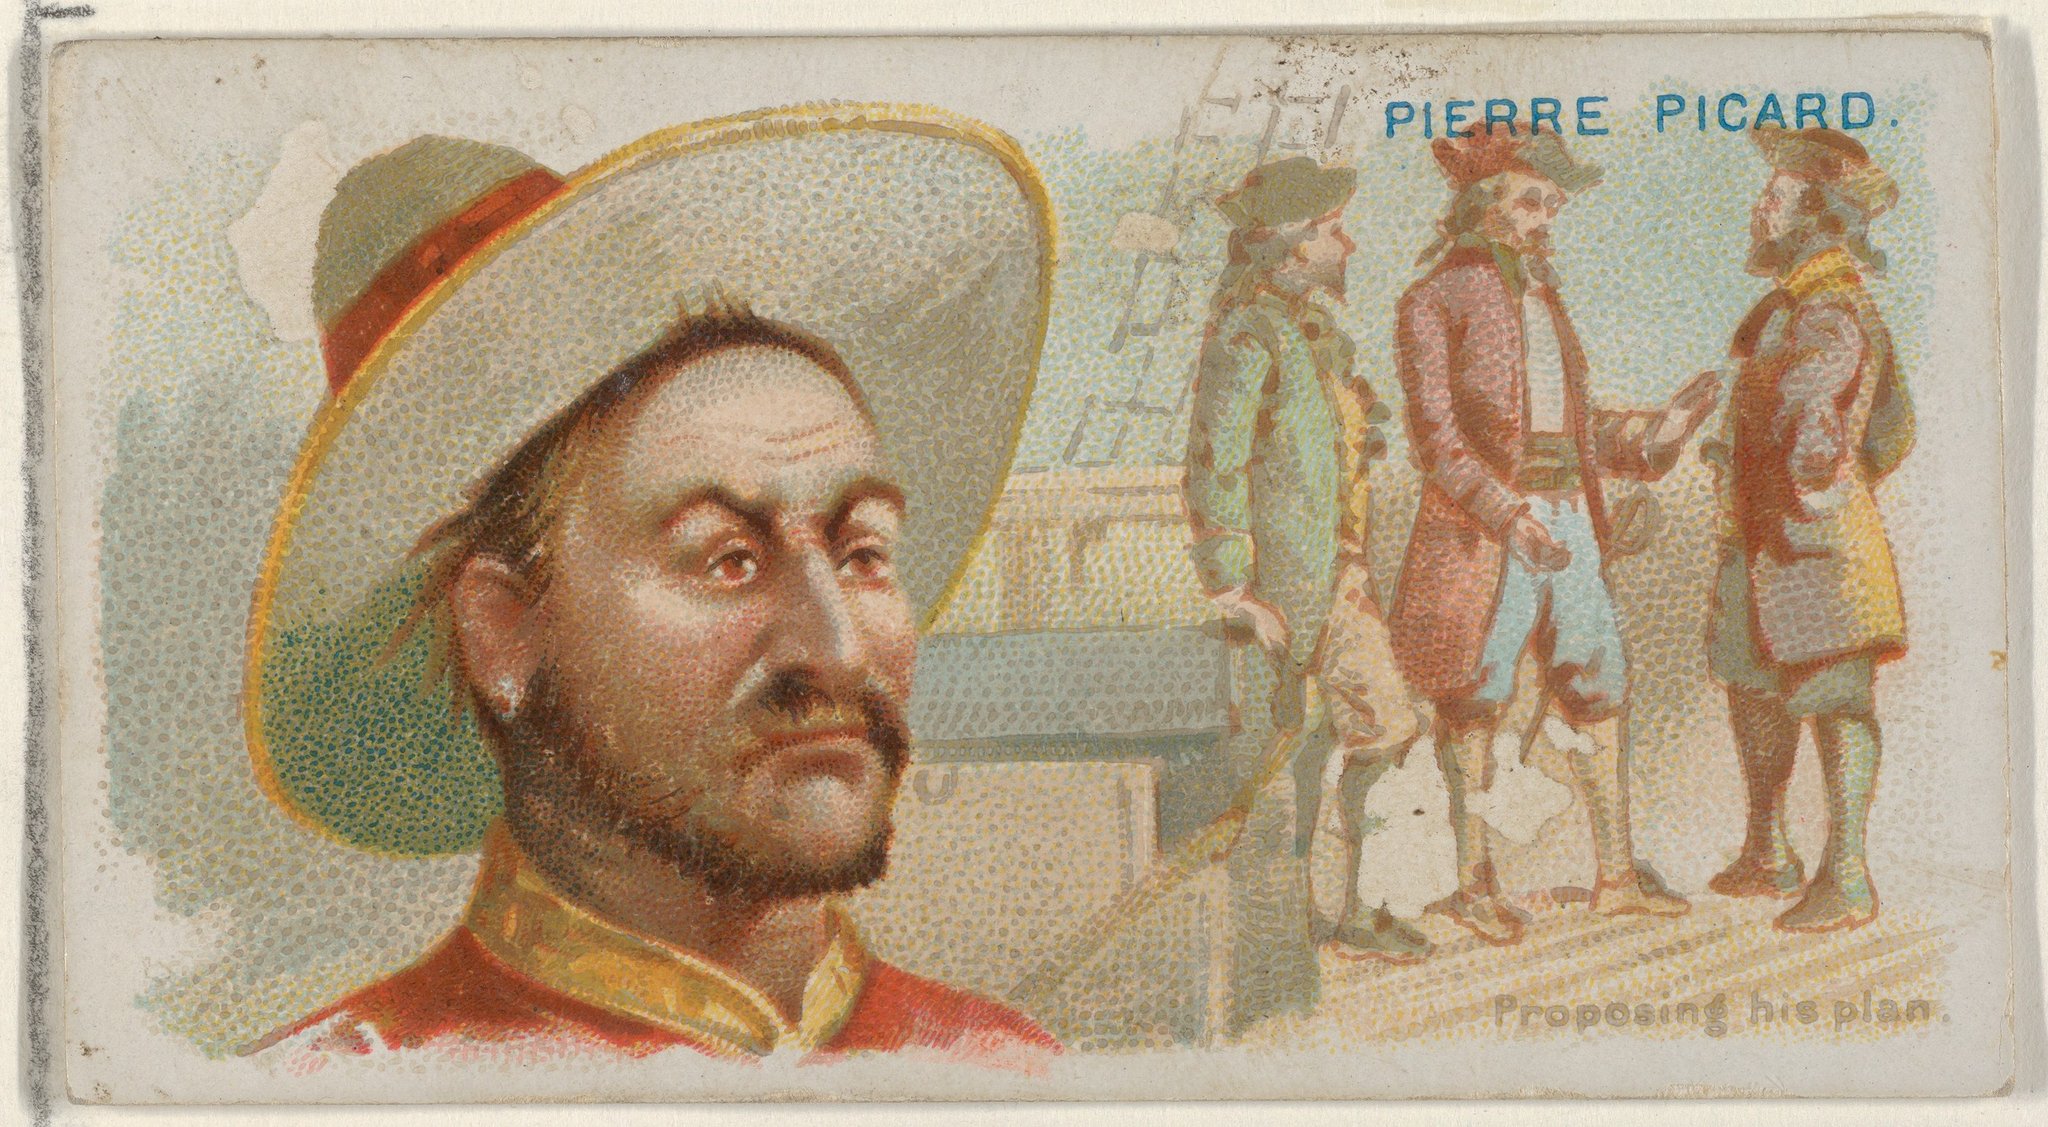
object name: print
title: Pierre Picard, Proposing His Plan, from the Pirates of the Spanish Main series (N19) for Allen & Ginter Cigarettes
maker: allen & ginter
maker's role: publisher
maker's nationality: american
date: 1888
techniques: color lithograph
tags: men